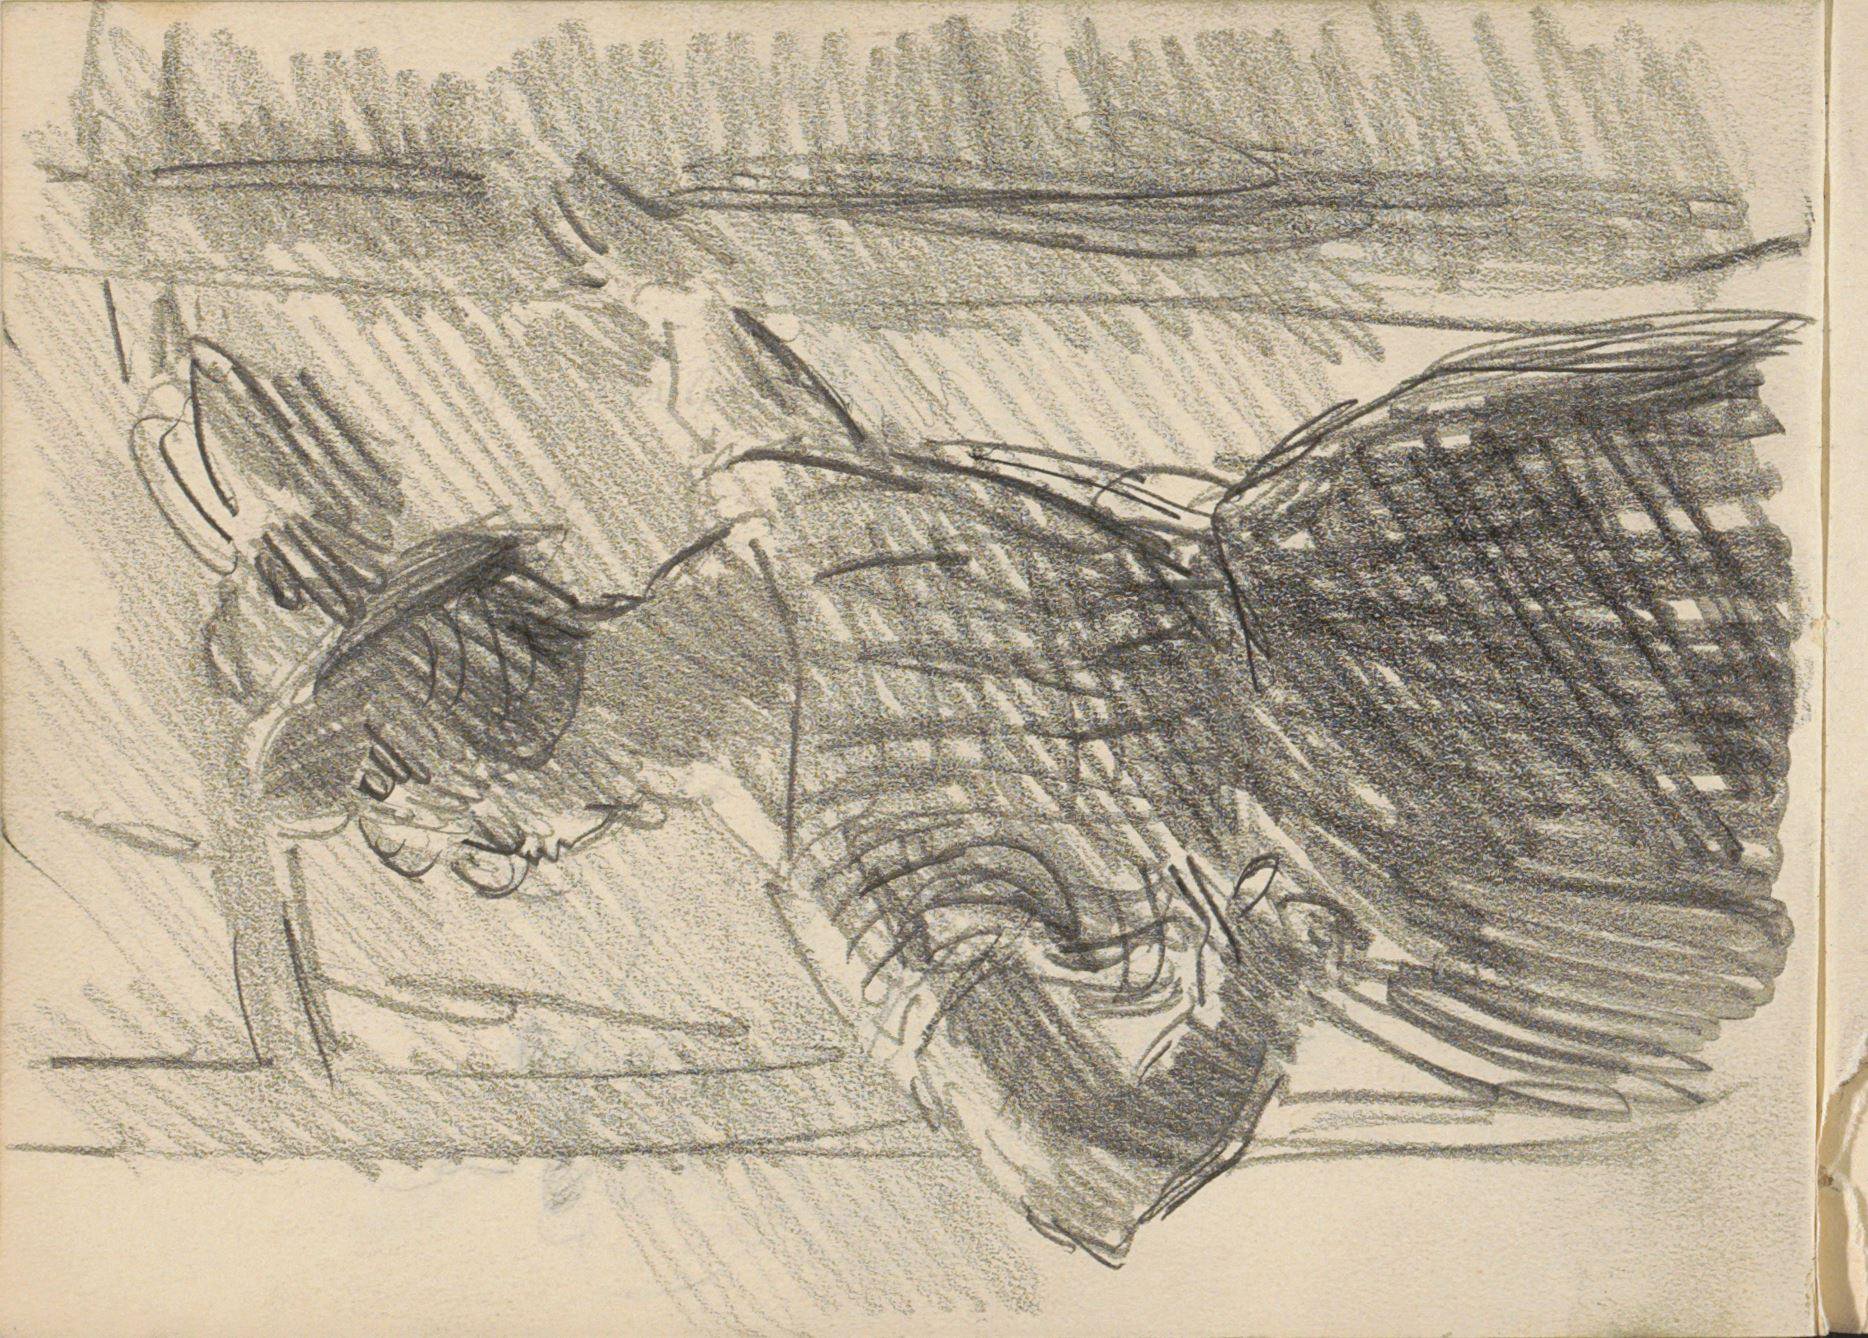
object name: sketchbook leaf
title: Staande vrouw, op de rug gezien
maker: isaac israels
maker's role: draughtsman, painter, print maker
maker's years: 1865-1934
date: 1930-1934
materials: paper, pencil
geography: the hague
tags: adult woman (+ standing)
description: Een hand in haar zij en met de andere leunt ze tegen een wand. Mogelijk een artiest. Pagina 19 uit schetsboek XXXVIII met 45 pagina's.